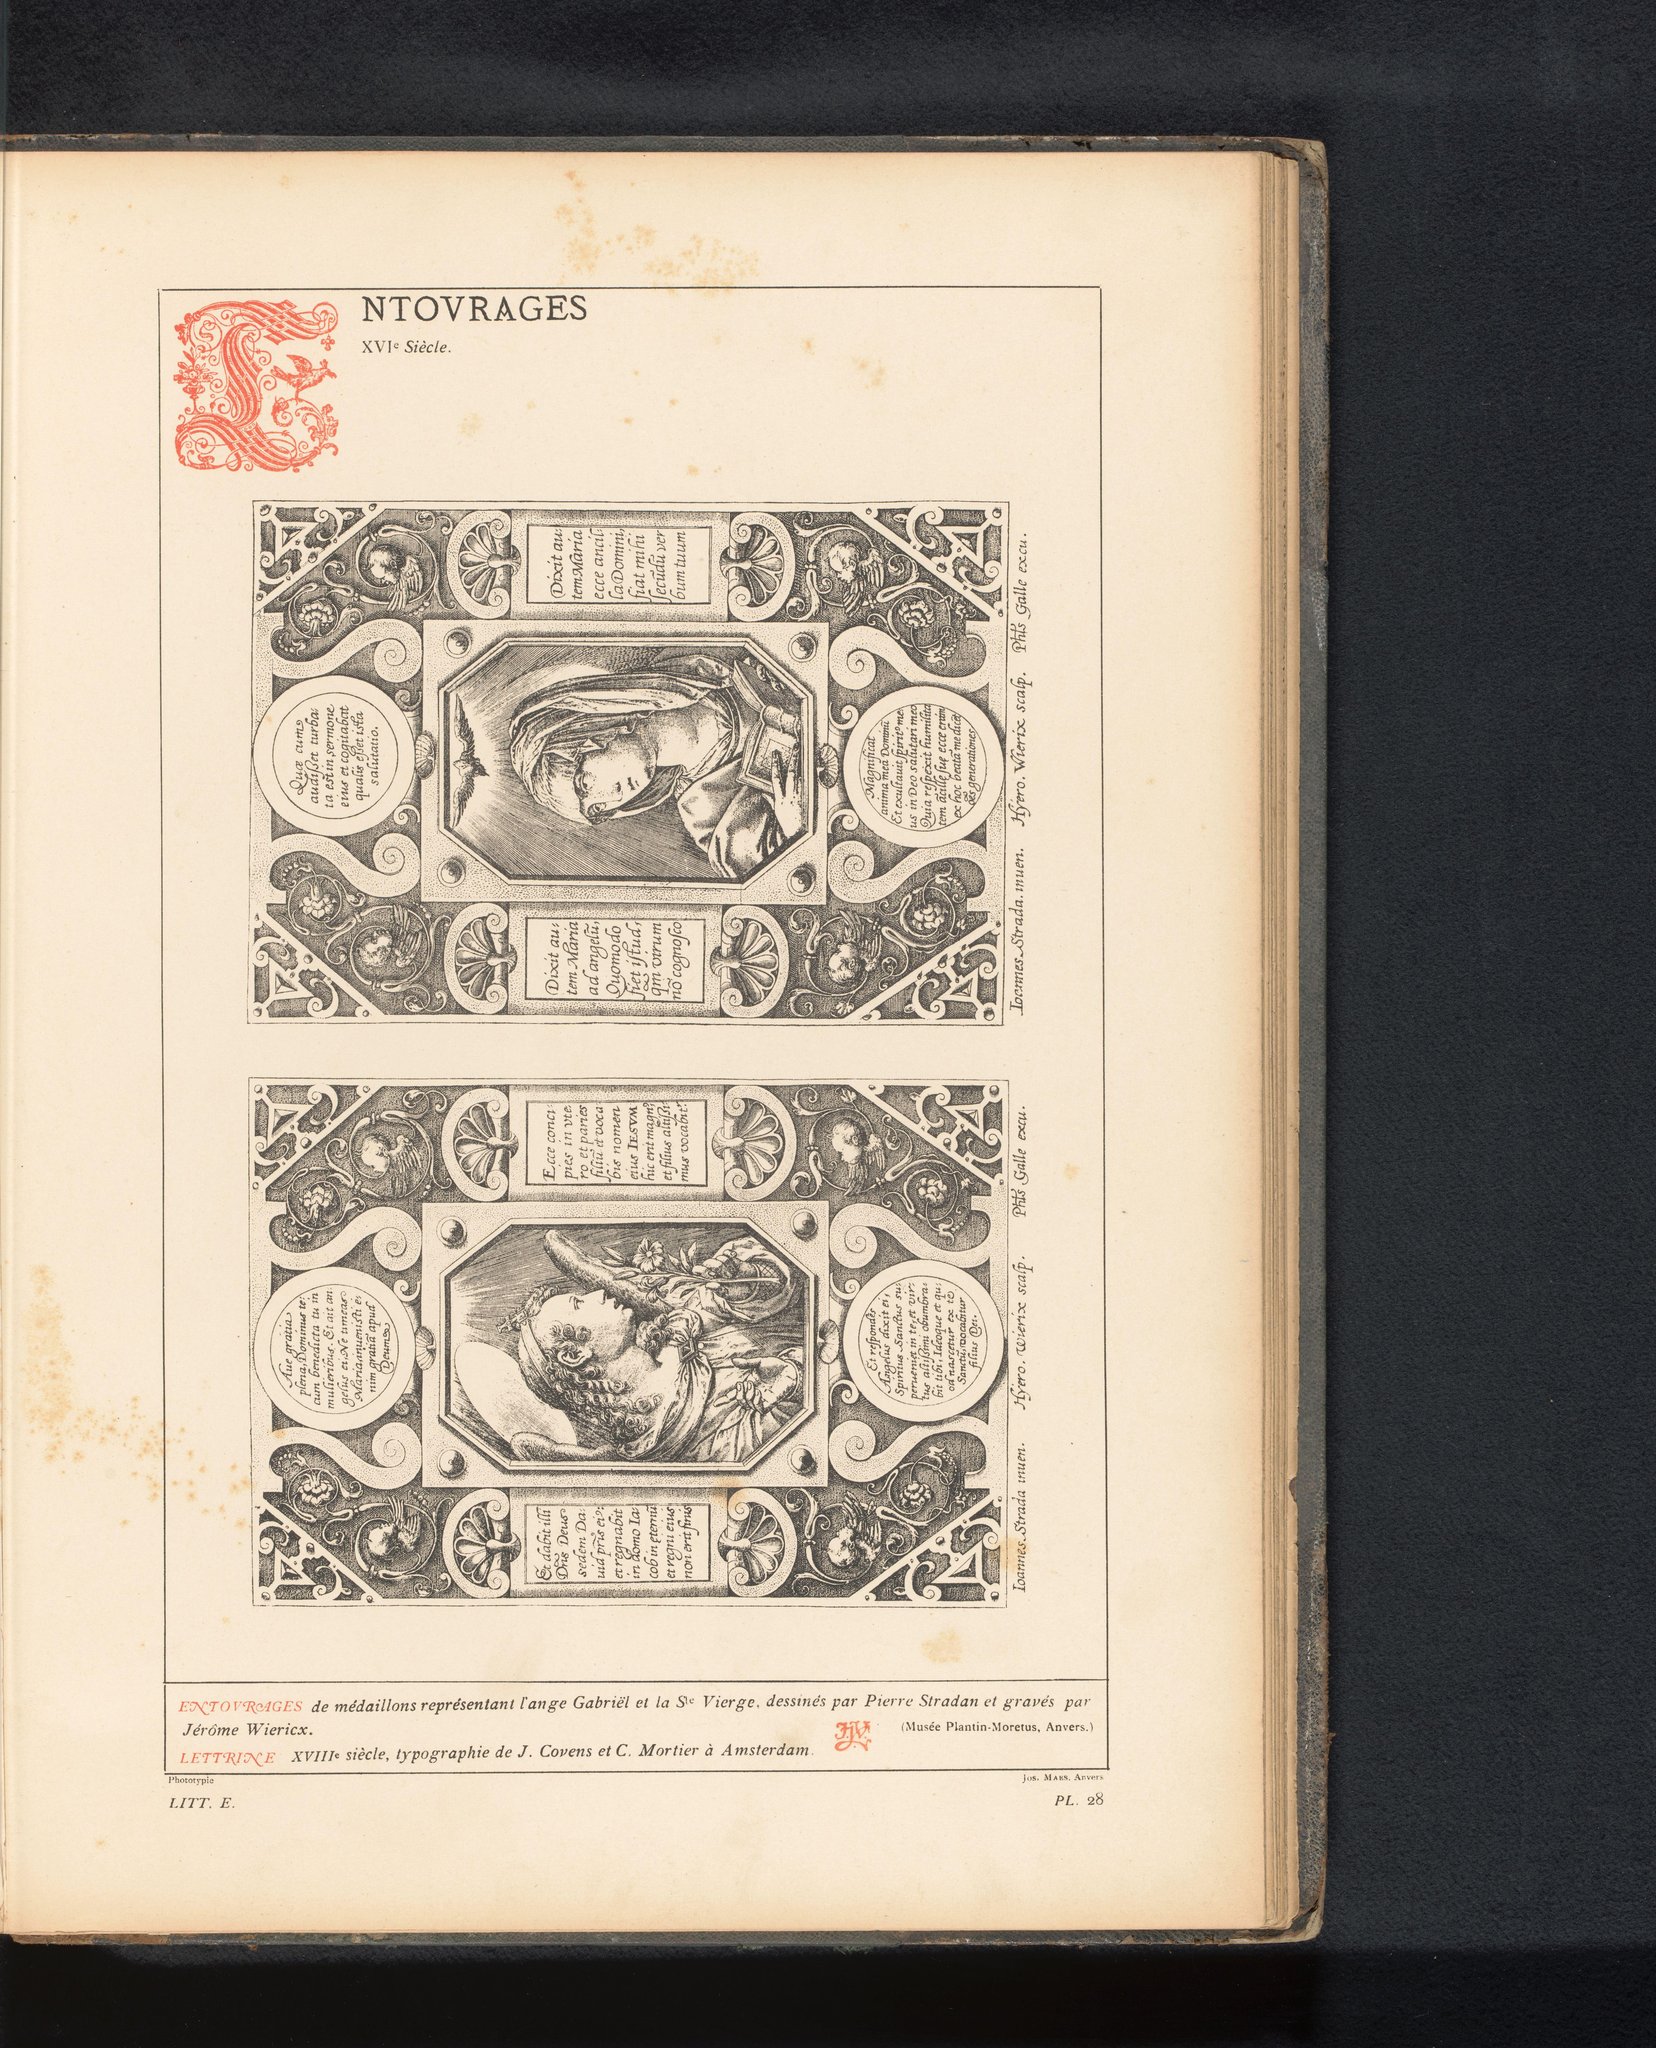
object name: page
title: Reproductie van twee prenten van de engel Gabriël en van Maria omringd door grotesken, door Johannes Wierix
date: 1875-1880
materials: paper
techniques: photolithography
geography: amsterdam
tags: ornament ~ grotesque, the archangel gabriel, the virgin mary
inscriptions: inscription: ‘ENTOURAGES de médaillons (...)’, inscription: ‘LITT. E. - PL. 28’, monogram: ‘JJvY’